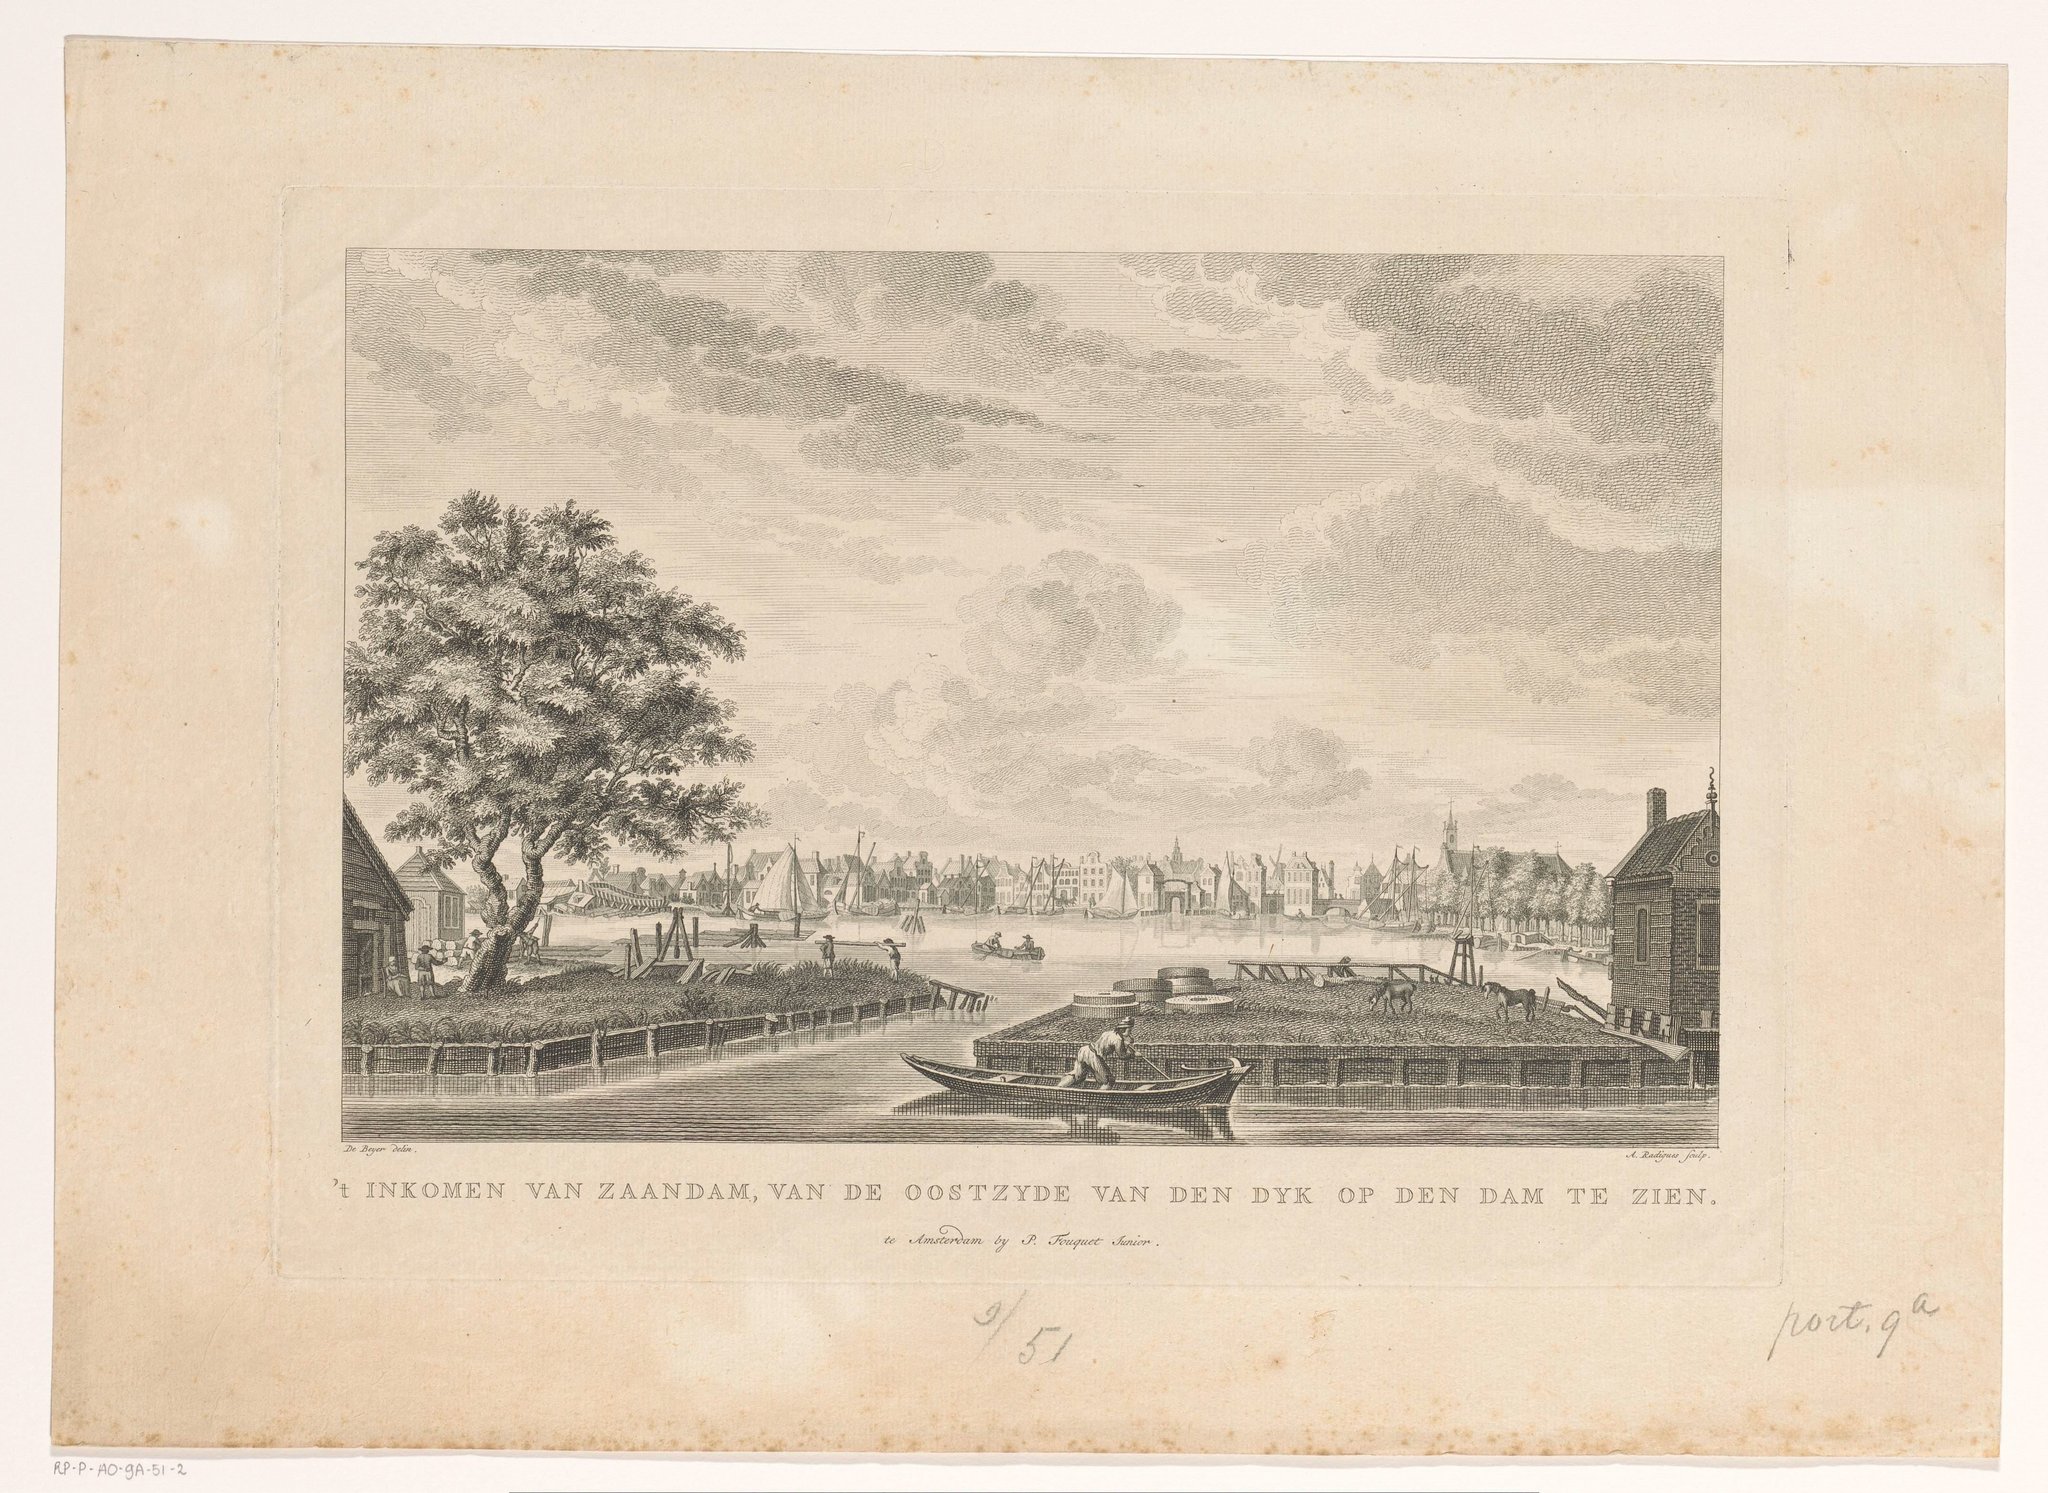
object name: print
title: 't Inkomen van Zaandam, van de oostzyde van den dyk op den dam te zien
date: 1753-1800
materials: paper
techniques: etching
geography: amsterdam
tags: sailing-ship, sailing-boat, church (exterior), rowing-boat, canoe, etc.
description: Gezicht op Zaandam en de toegang tot de haven, gezien vanaf de Zaan aan de oostzijde van de dijk.